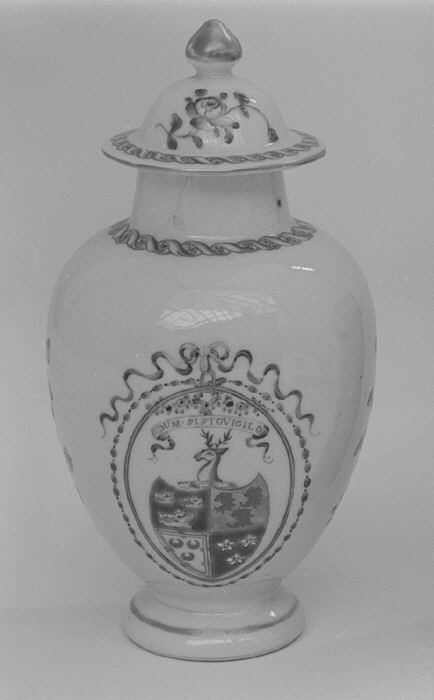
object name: tea caddy with cover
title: Tea caddy with cover (part of a service)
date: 1770-1785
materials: hard paste porcelain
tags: coat of arms